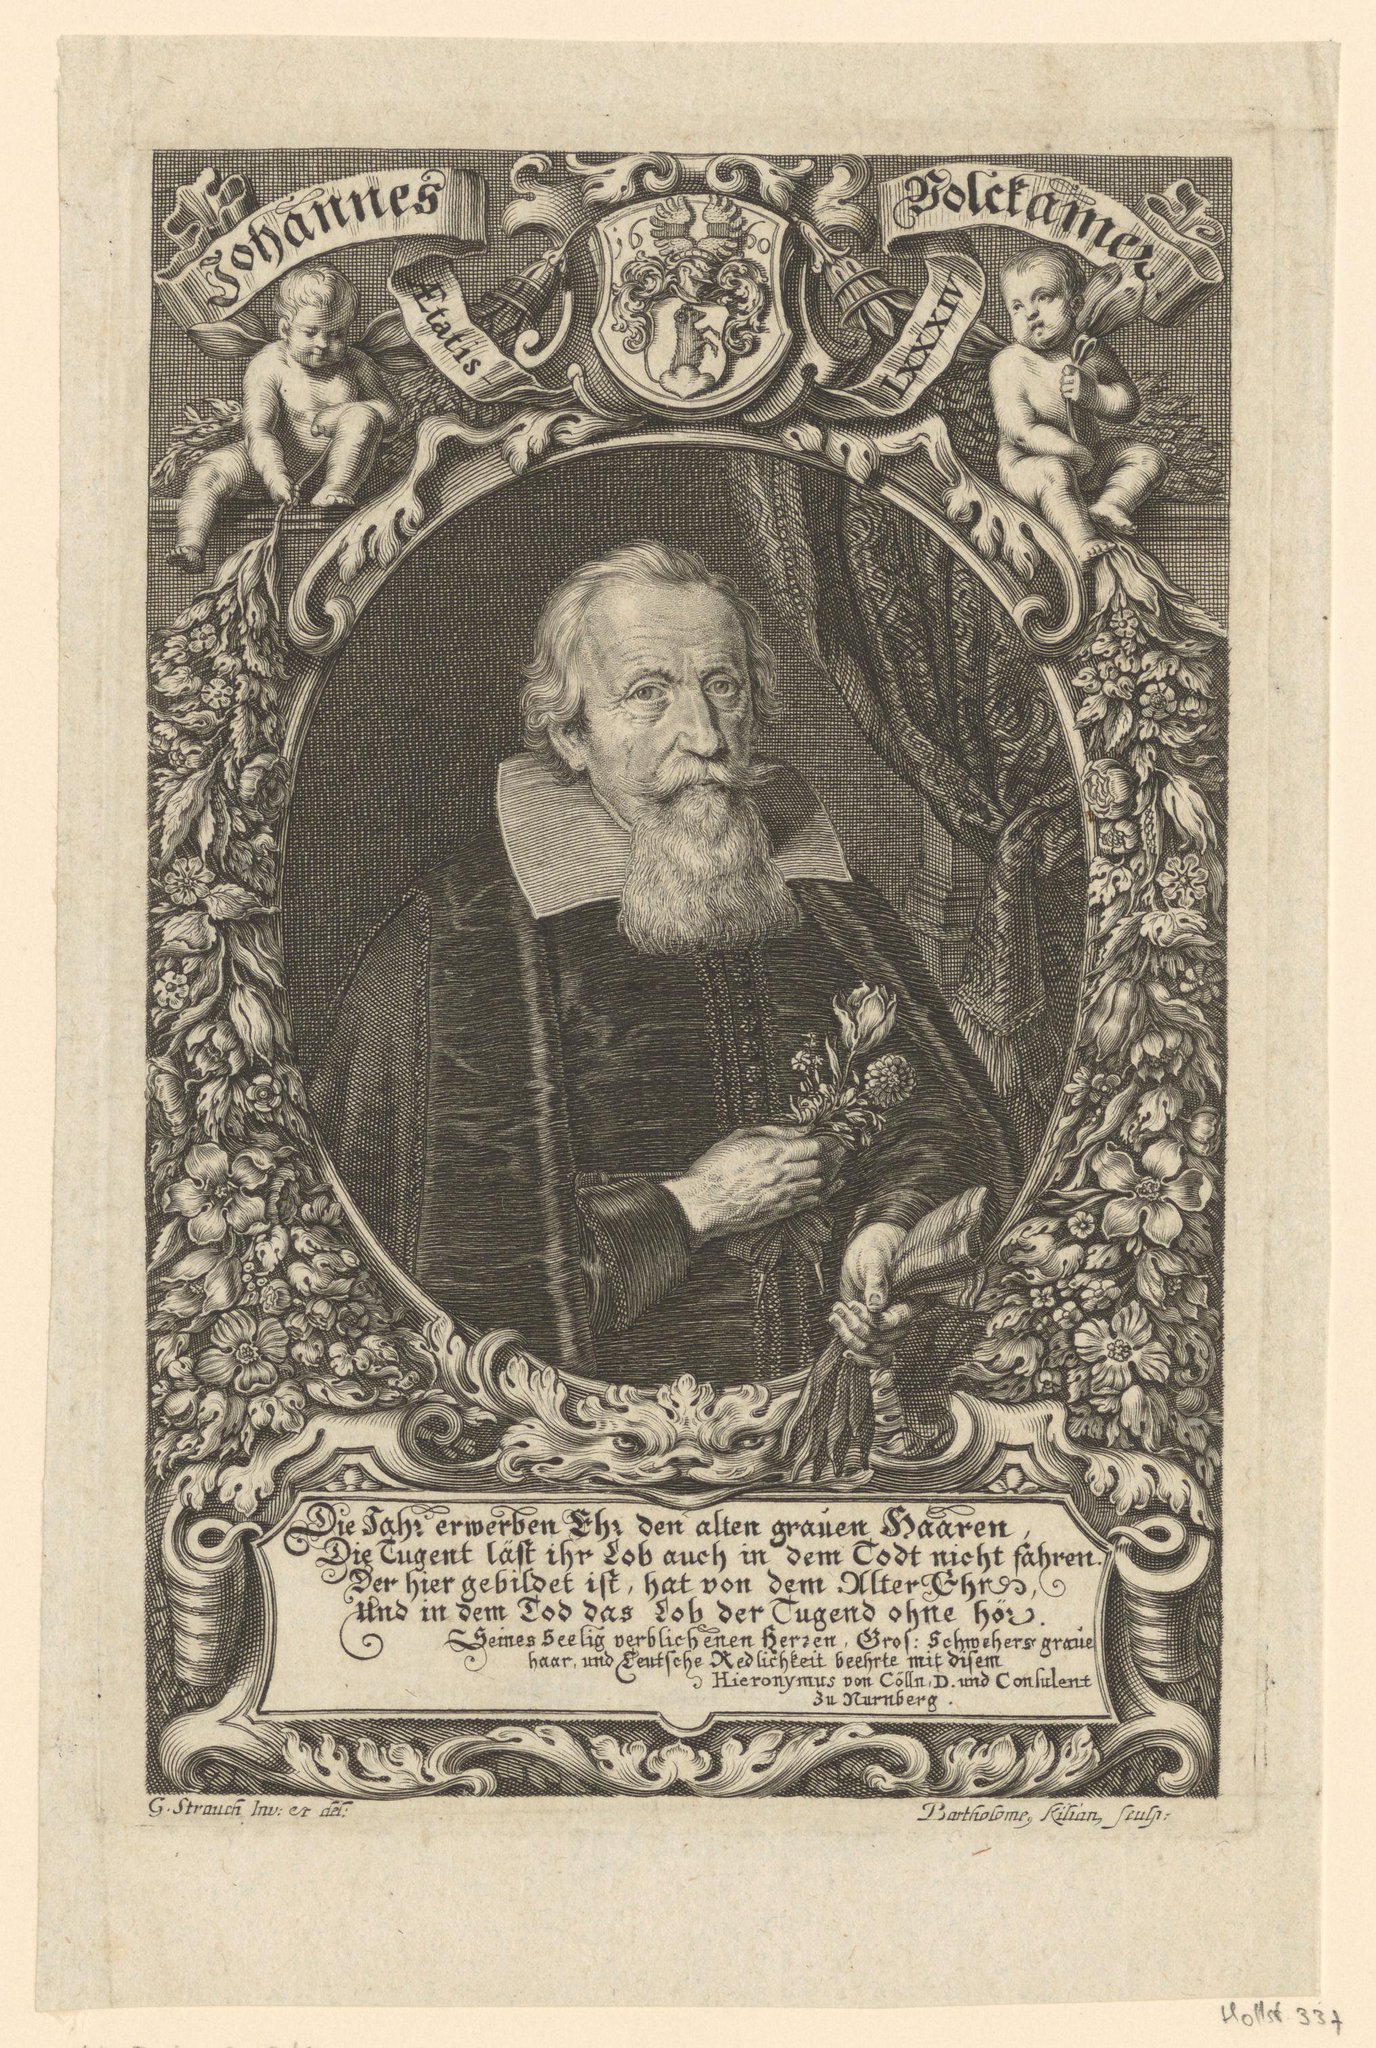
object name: print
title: Portret van Johann Volckamer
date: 1660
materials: paper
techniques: engraving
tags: city council, botany (+ portrait of scholar, scientist), historical persons, merchant, salesman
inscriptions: collector's mark: Lugt 2228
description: Tekst in het Duits in de cartouche onderin en in het Latijn op banderollen bovenaan.